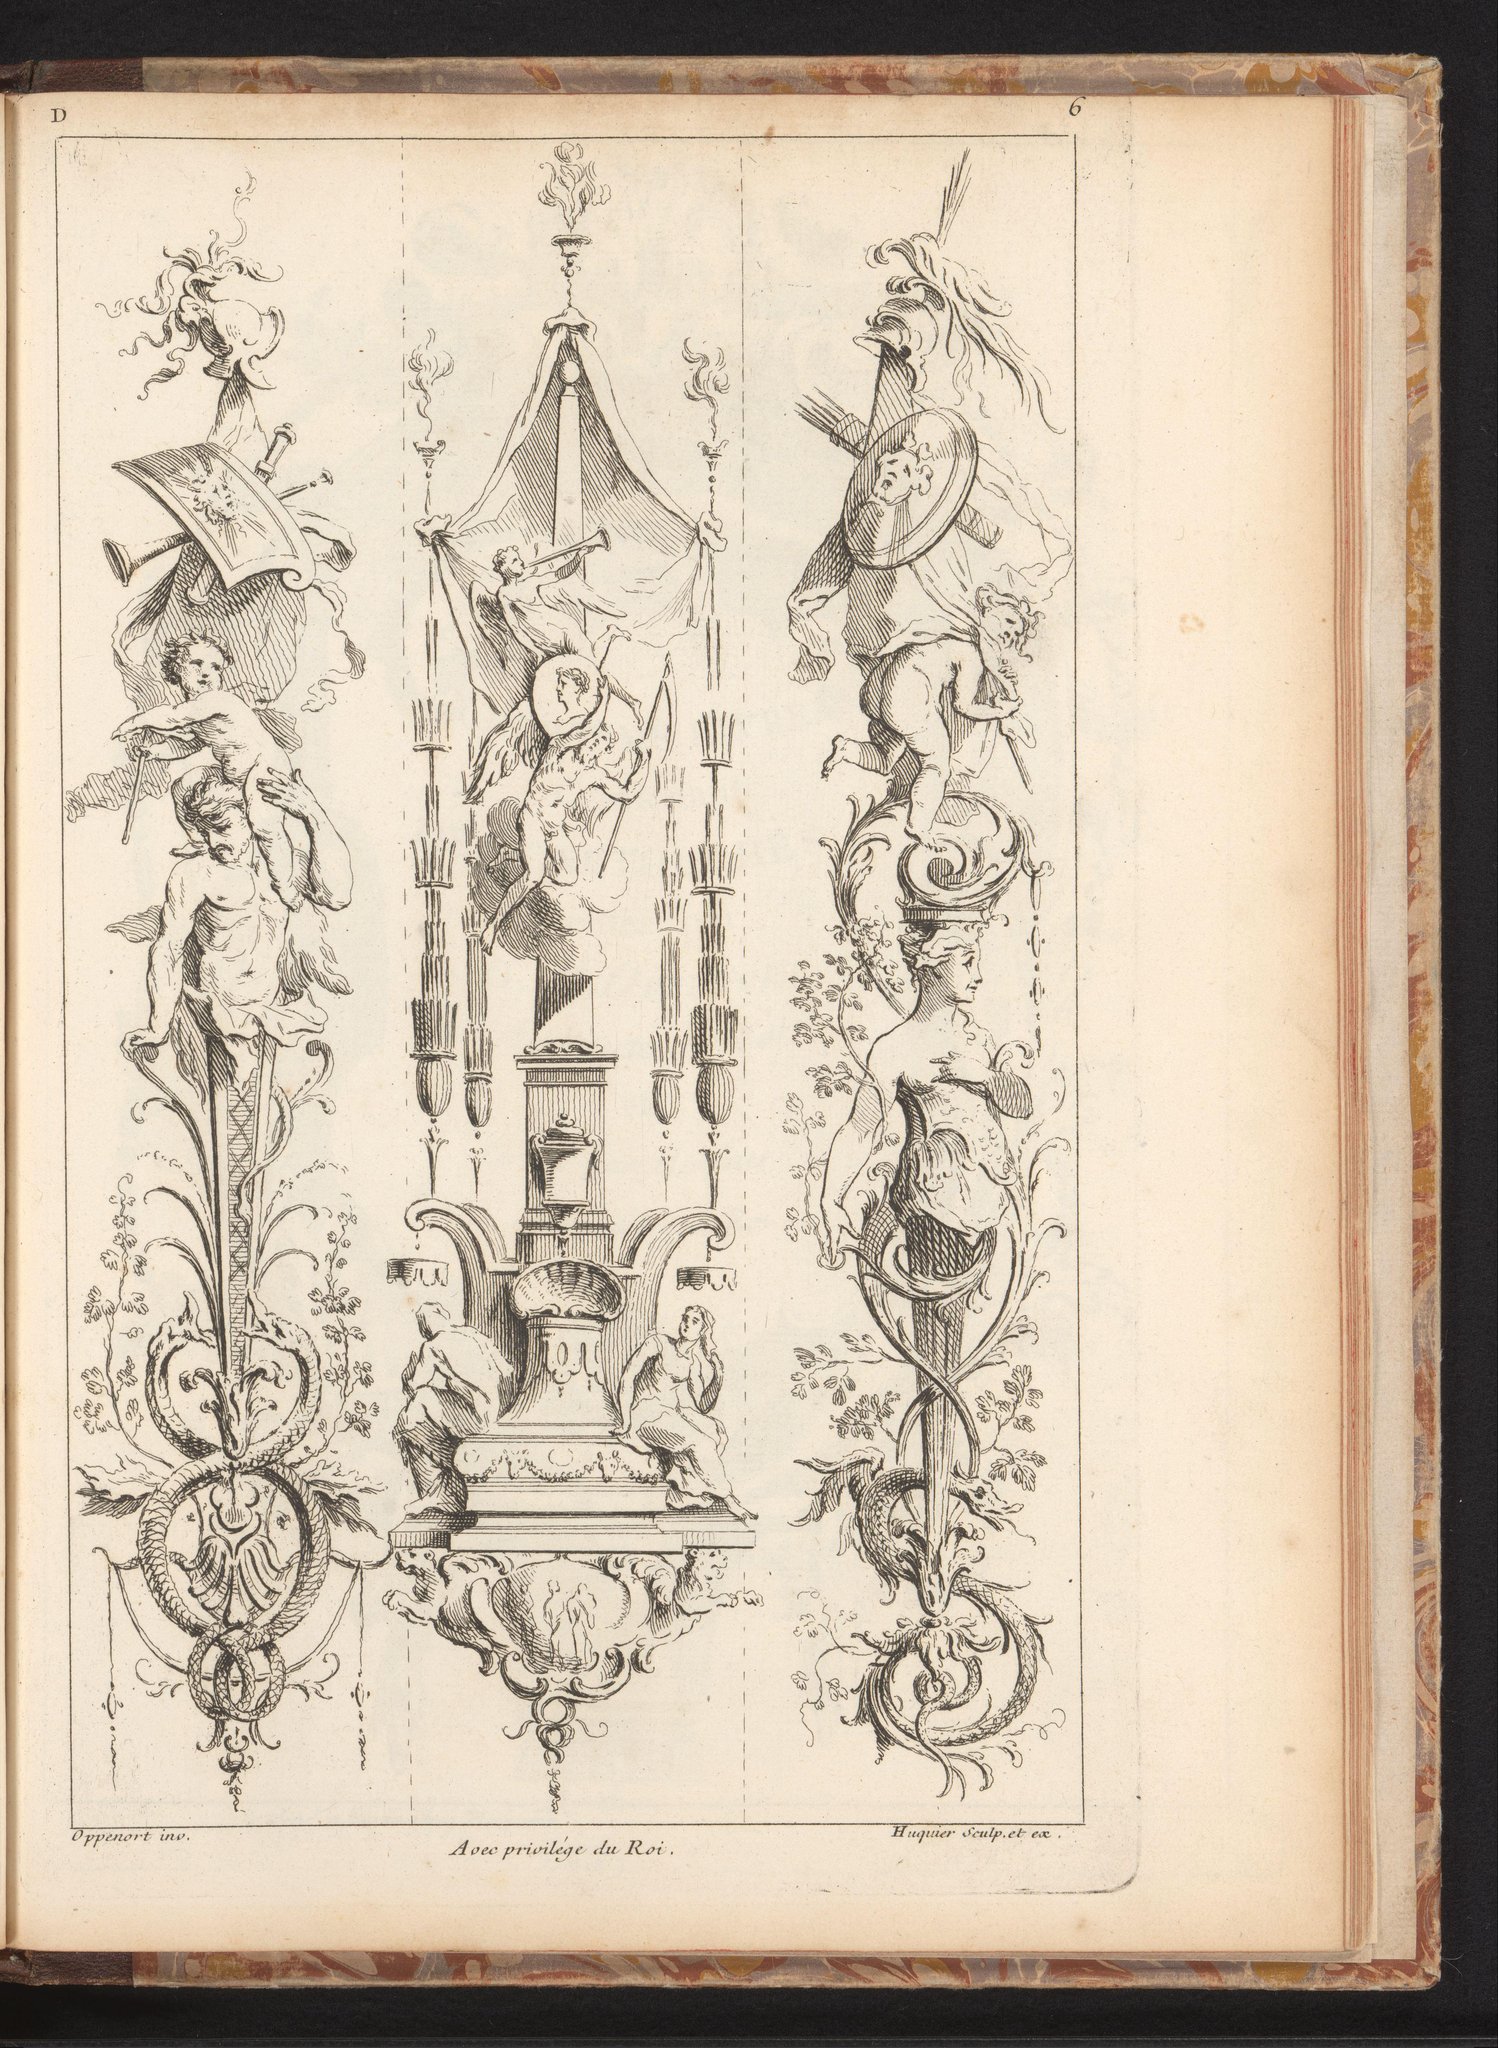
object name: ornament print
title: Drie ontwerpen voor muurornamenten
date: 1725-1750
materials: paper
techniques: etching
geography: paris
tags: ornaments ~ art, herms (garden ornaments), ornament ~ medallion, cupids: 'amores', 'amoretti', 'putti', father time, man with wings and scythe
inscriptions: collector's mark: Lugt 2228a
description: Links een man met op zijn schouder een putto met een vaandel. In het midden Vader Tijd met een medaillon. Rechts een herm met daarboven een putto met een vaandel en ander wapentuig. Deze prent maakt deel uit van een album.